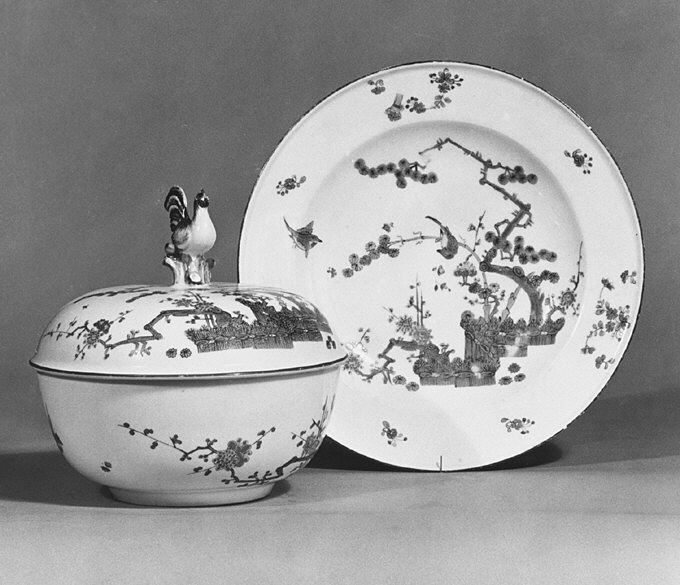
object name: bowl with cover and stand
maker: meissen manufactory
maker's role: manufactory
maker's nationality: german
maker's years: 1710-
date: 1730-1735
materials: hard paste porcelain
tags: birds,chickens